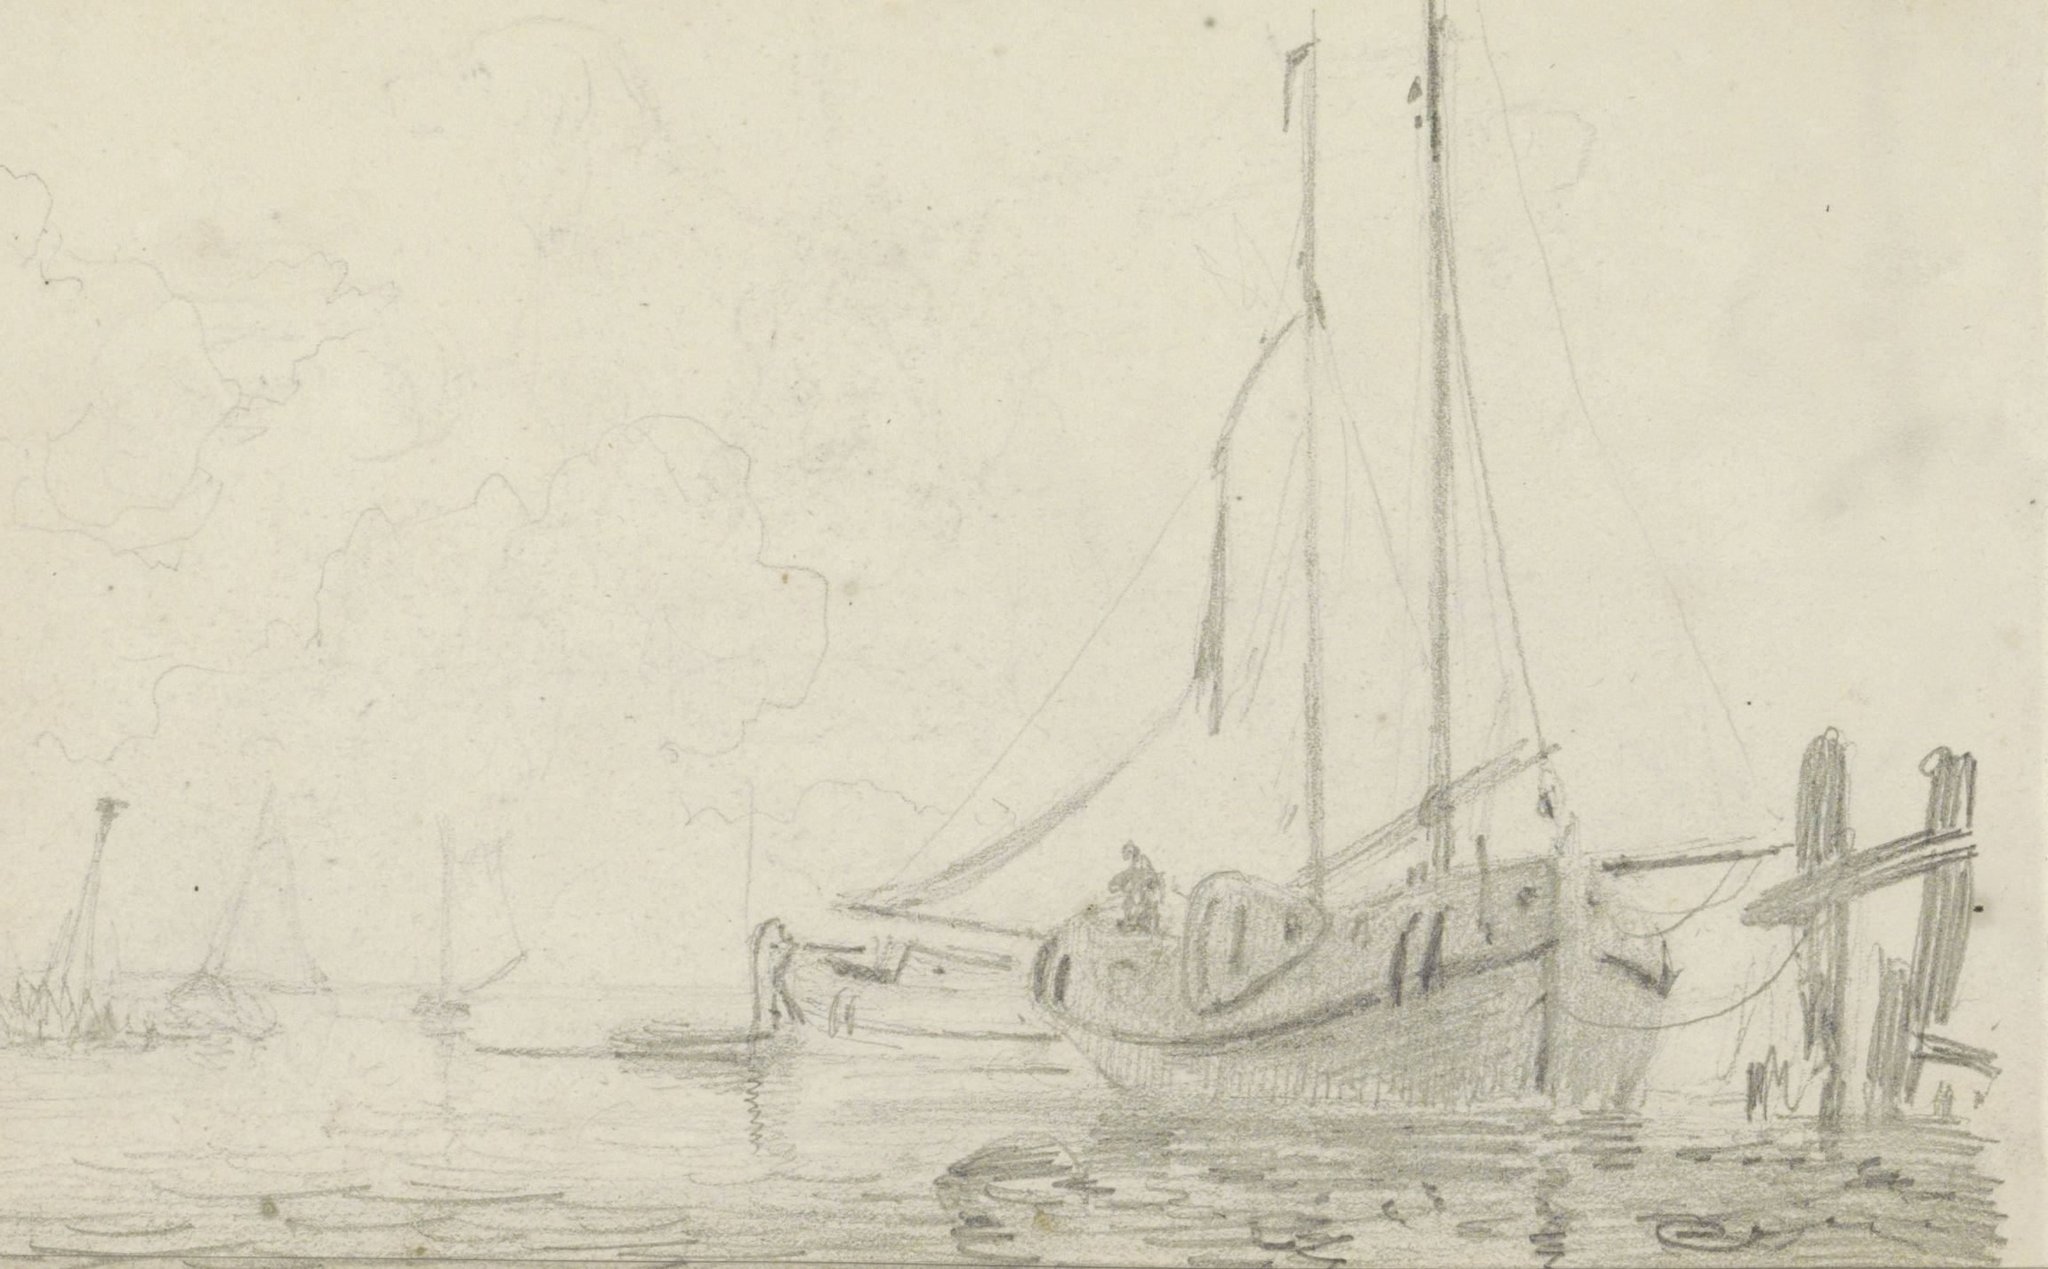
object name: sketchbook leaf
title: Rivierlandschap met zeilschepen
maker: adrianus eversen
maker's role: draughtsman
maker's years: 1818-1897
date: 1828-1897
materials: paper, pencil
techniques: stumping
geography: netherlands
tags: sailing-ship, sailing-boat, landscapes with waters, waterscapes, seascapes (in the temperate zone)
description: Rivierlandschap met zeilschepen. Rechts liggen twee zeilschepen aangemeerd. Blad 11 verso uit een schetsboek met 27 bladen.